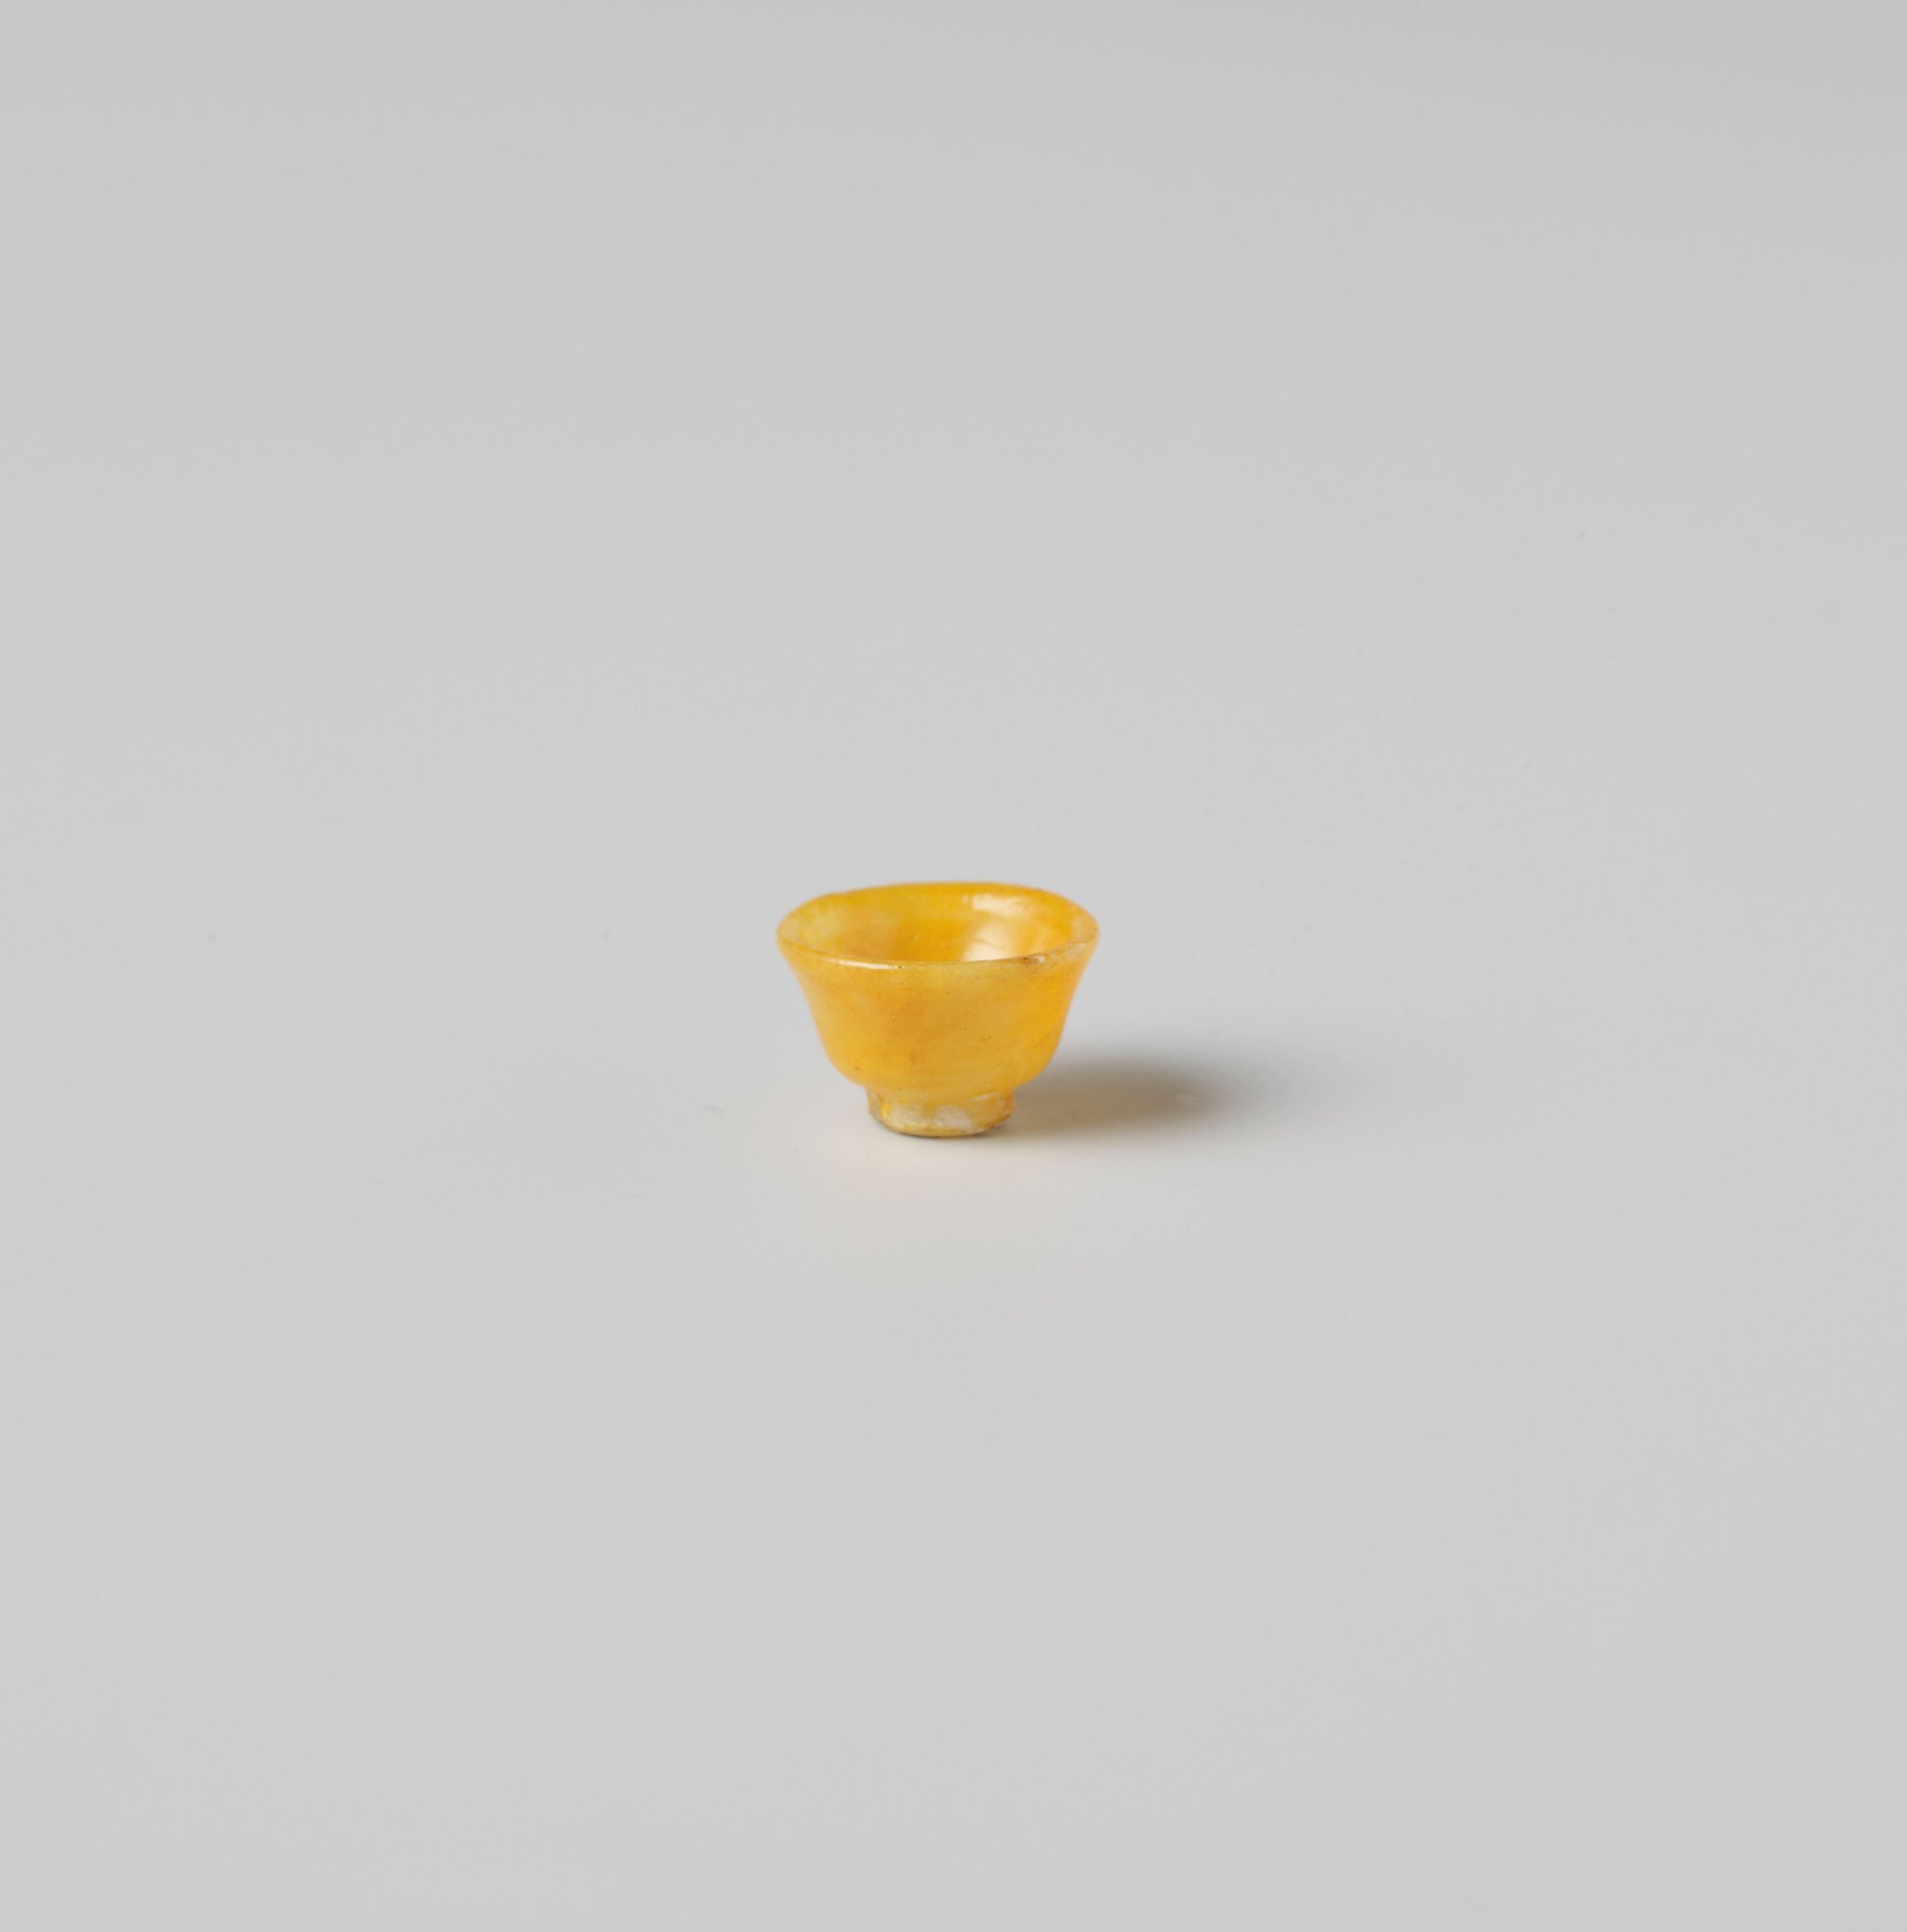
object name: bowl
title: Kom, geelgelakt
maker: Anonymous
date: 1750-1800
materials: alabaster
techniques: lacquer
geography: germany